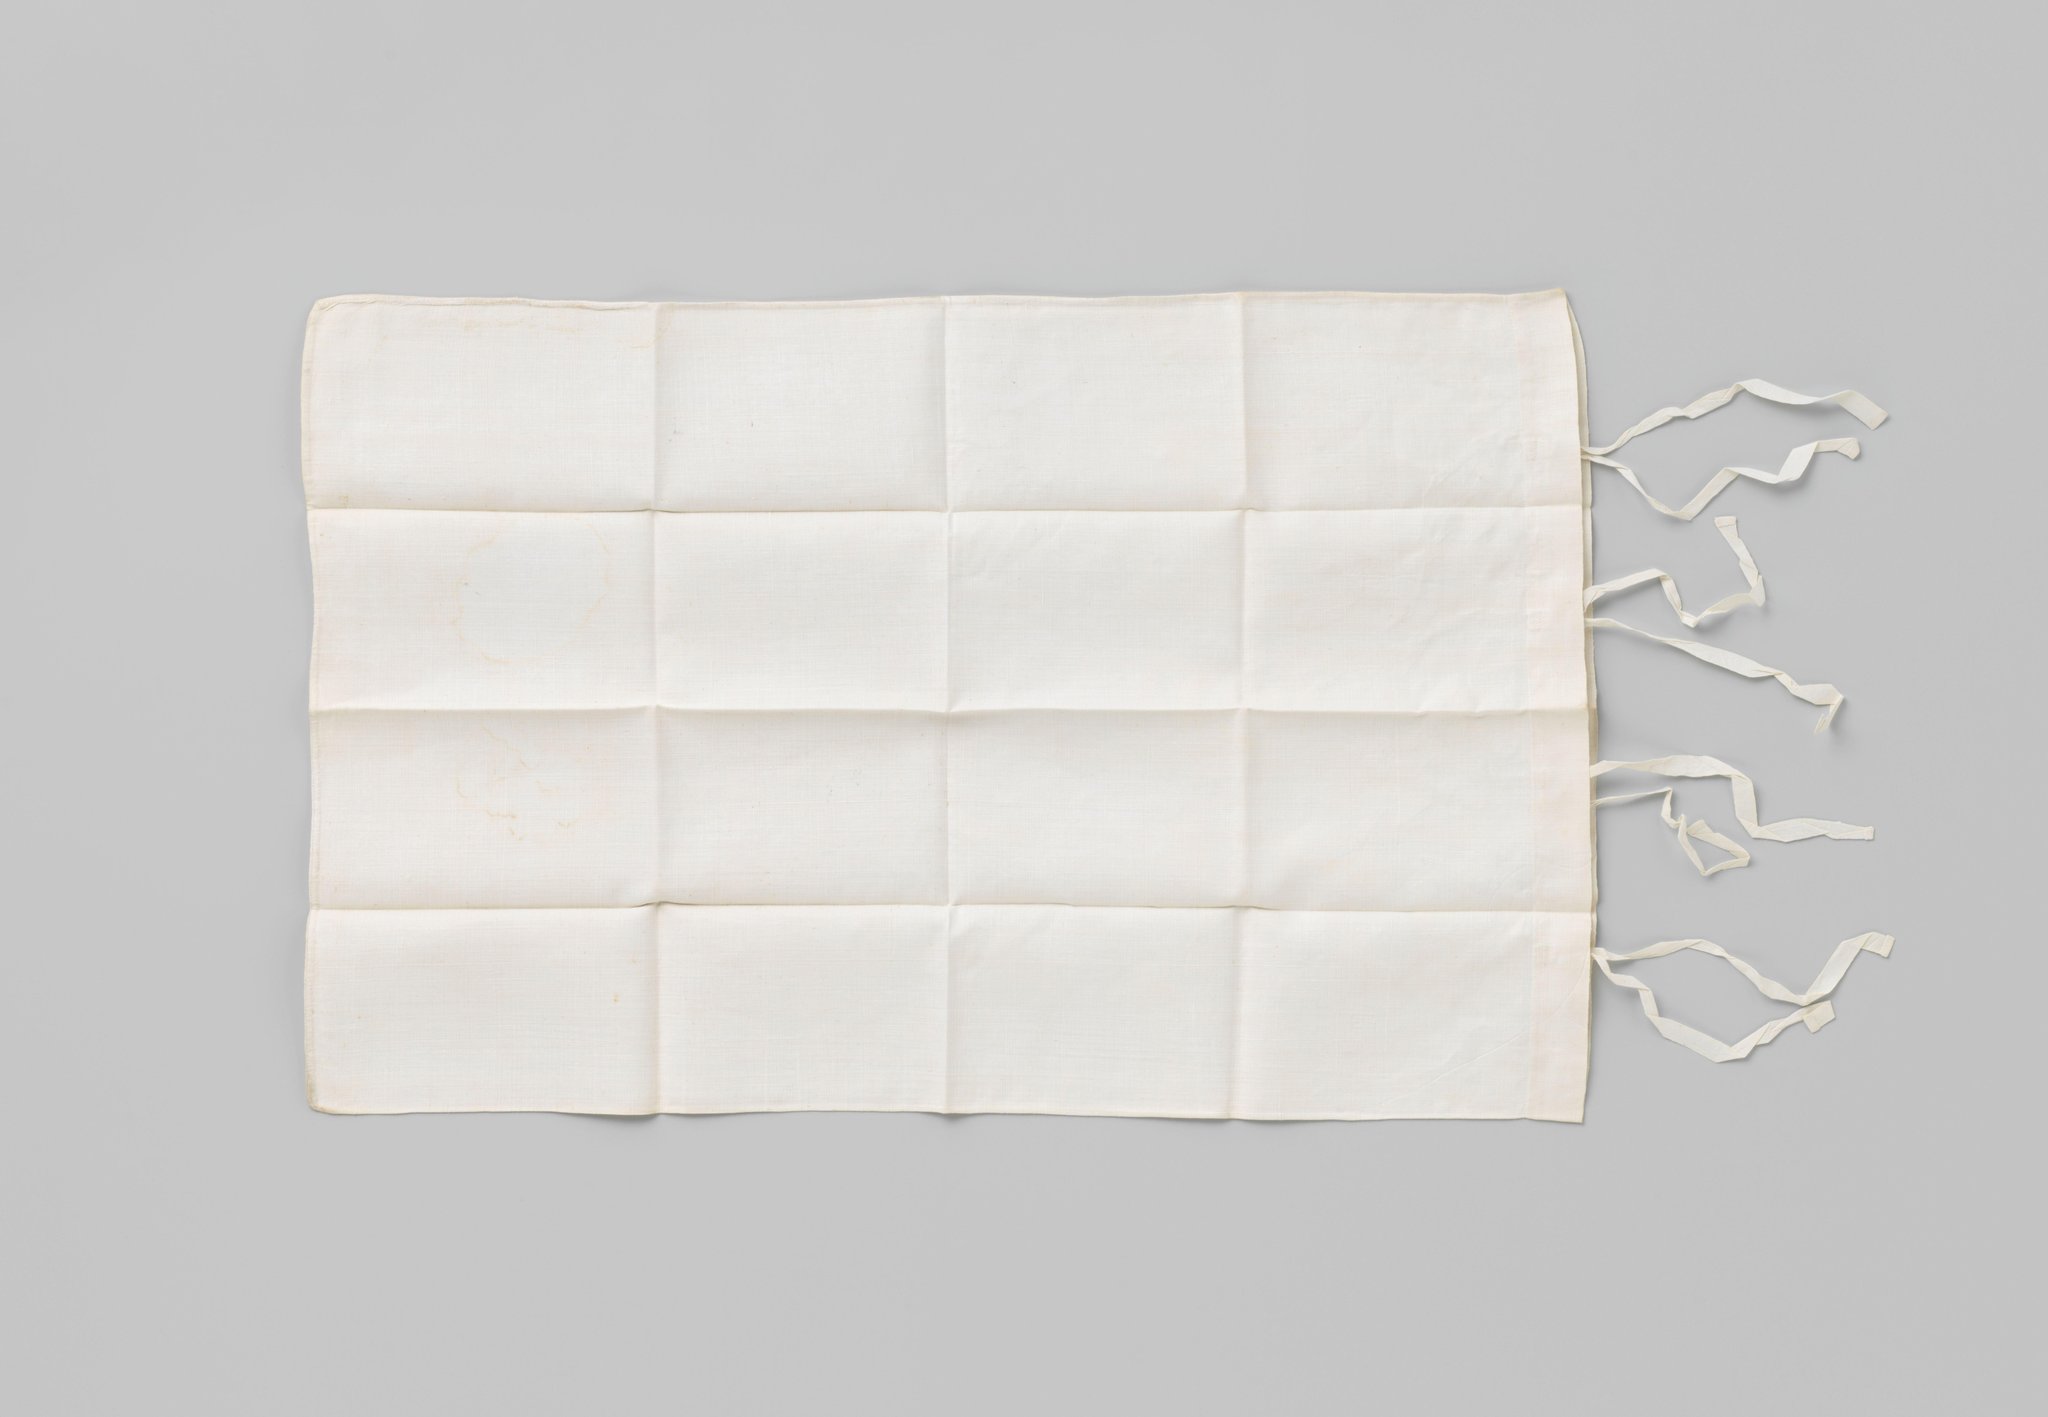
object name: lendensloop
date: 1820-1870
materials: linen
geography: northern netherlands